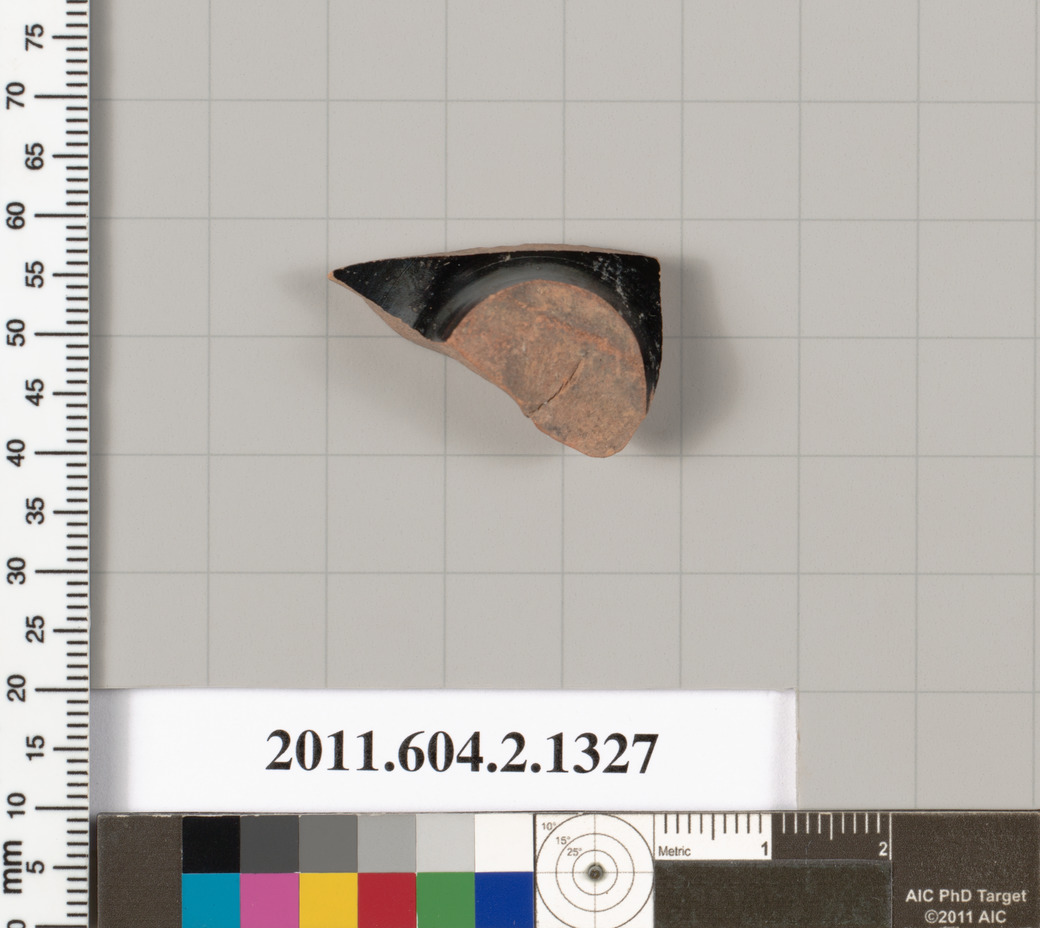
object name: skyphos fragment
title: Terracotta fragment of a skyphos (deep drinking cup)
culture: greek, attic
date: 600-401 BCE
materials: terracotta